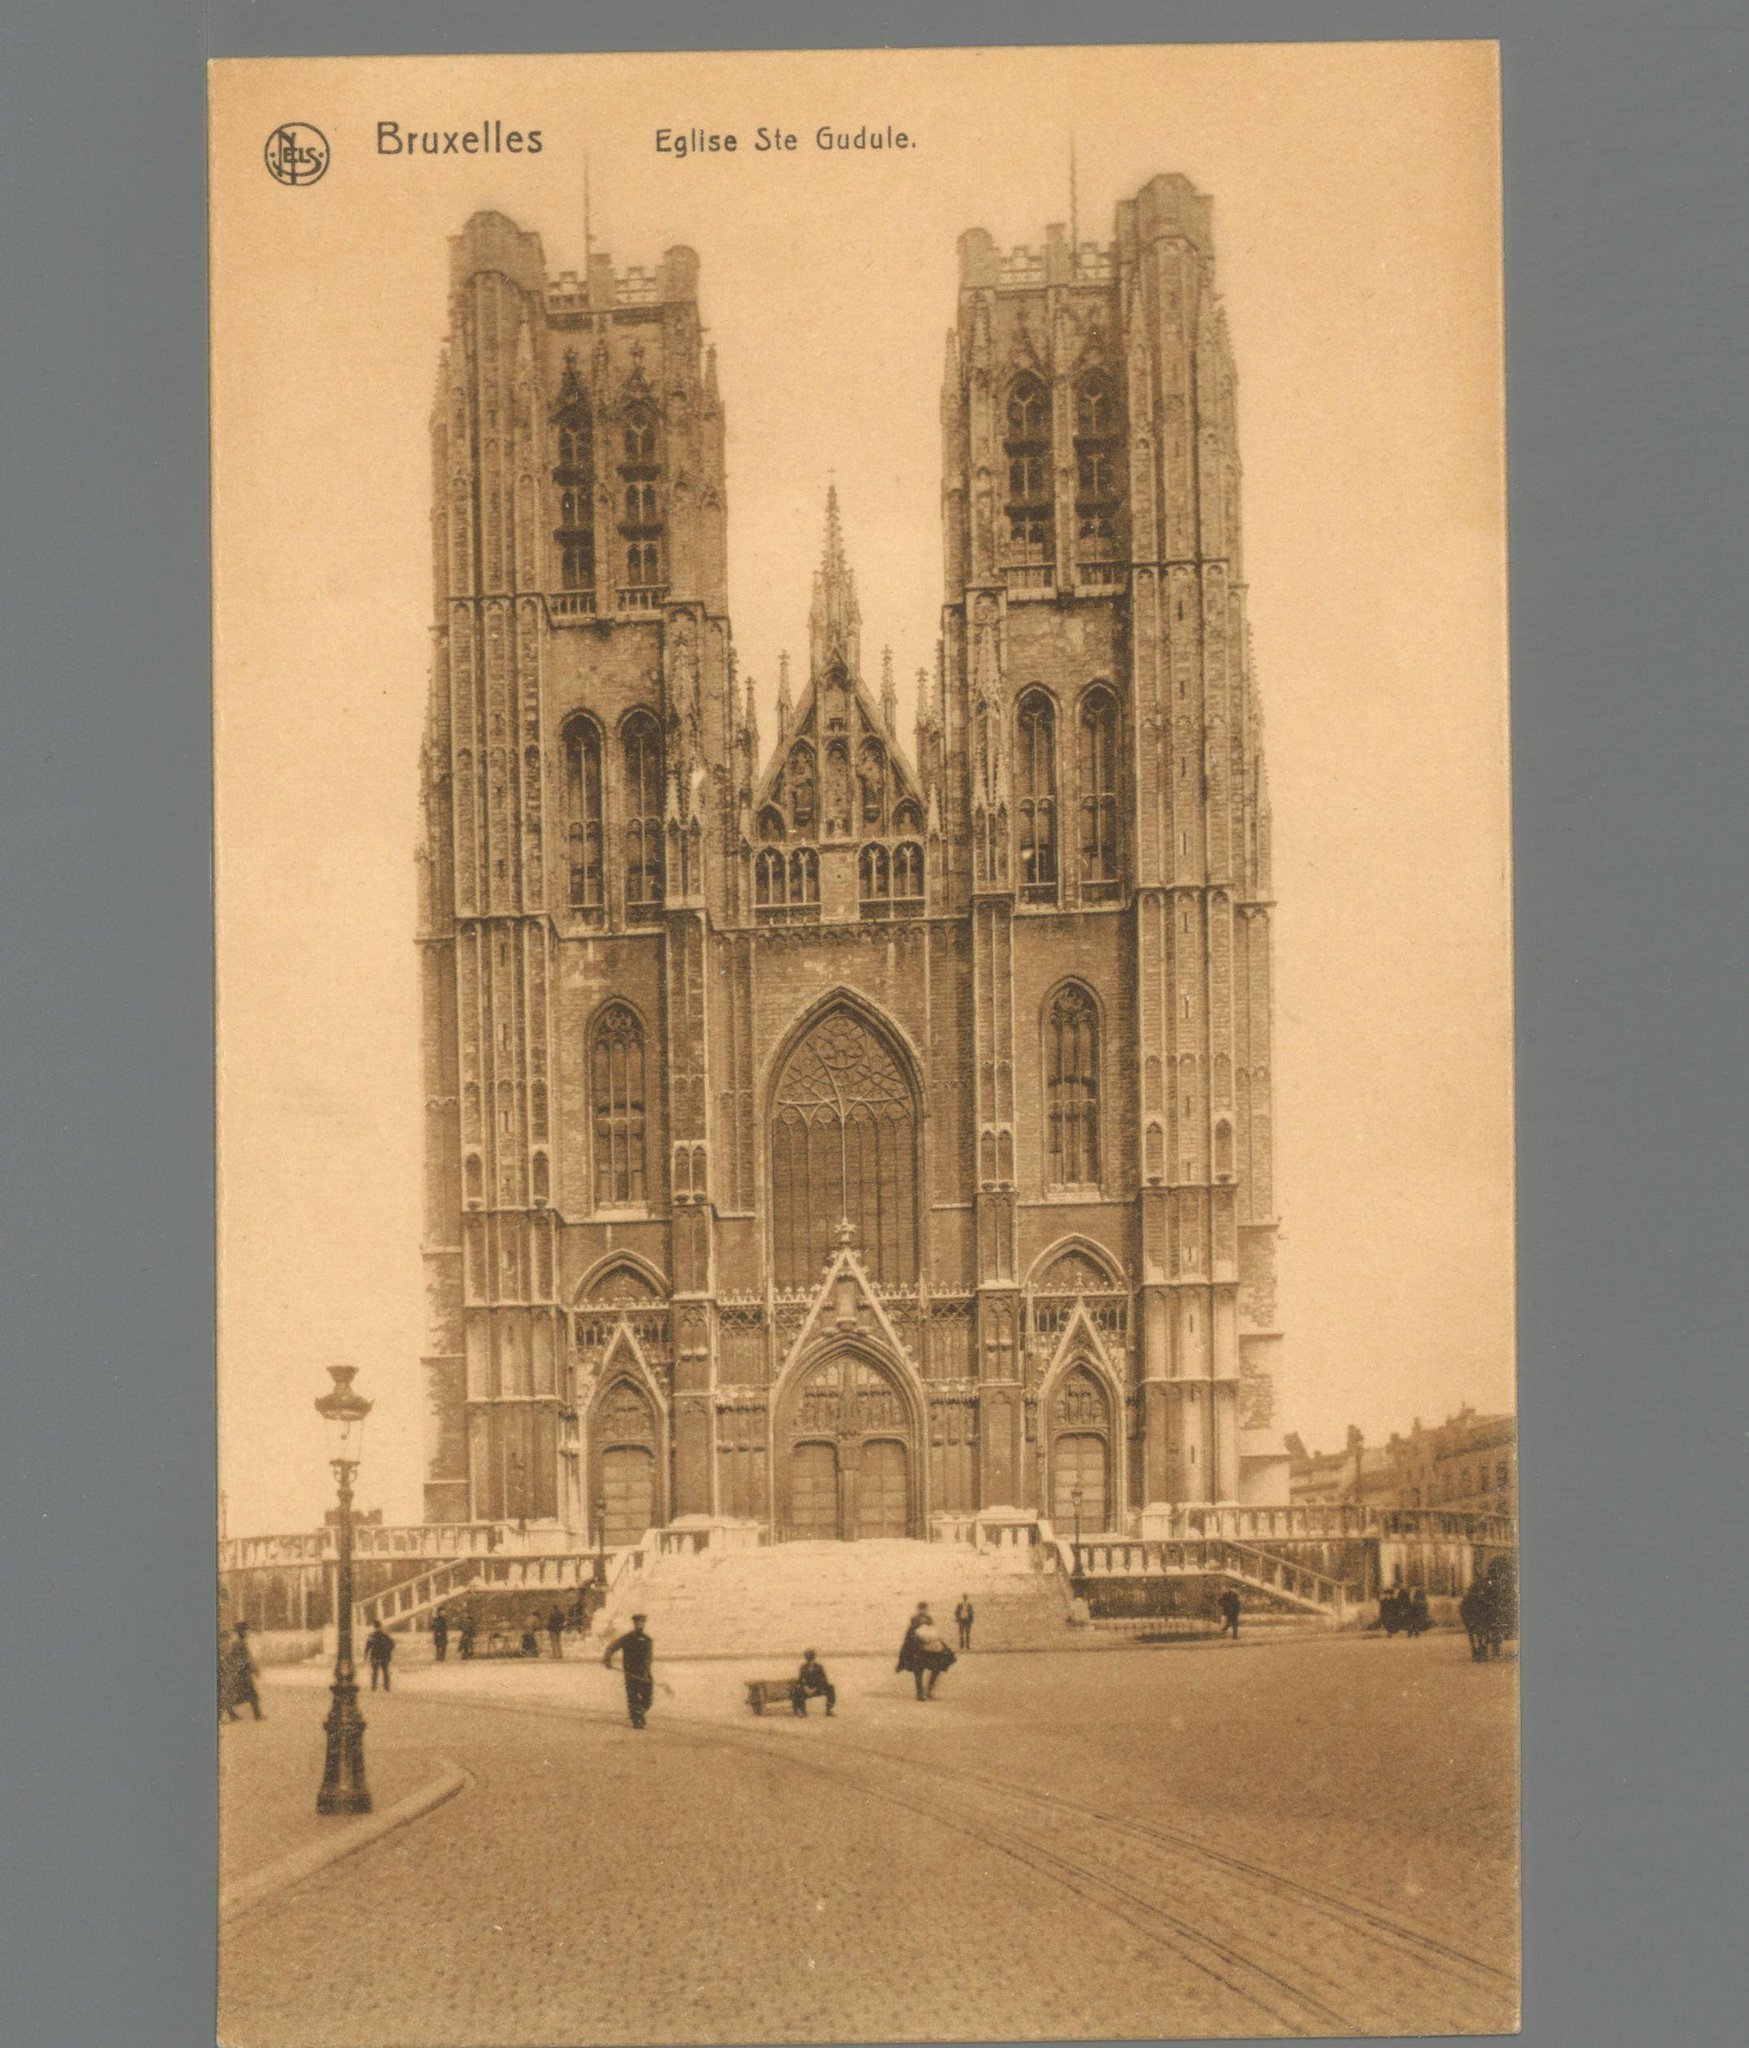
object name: photomechanical print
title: Bruxelles. Eglise Ste Gudule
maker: Anonymous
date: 1907-1913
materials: cardboard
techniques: photograph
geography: brussels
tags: church (exterior), city-view, and landscape with man-made constructions (+ city(-scape) with figures, staffage)